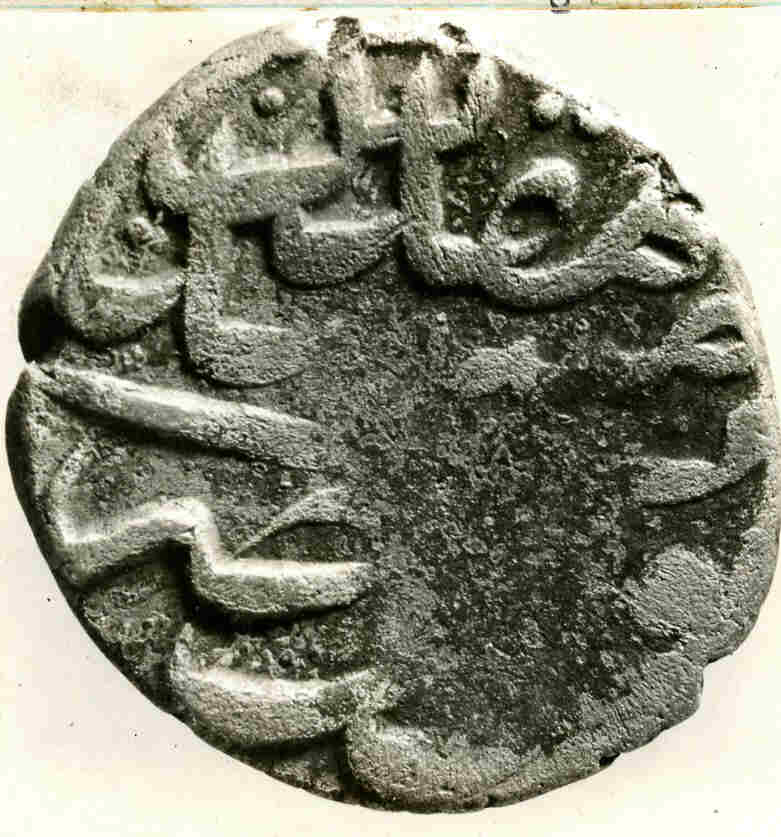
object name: coin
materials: copper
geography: iran